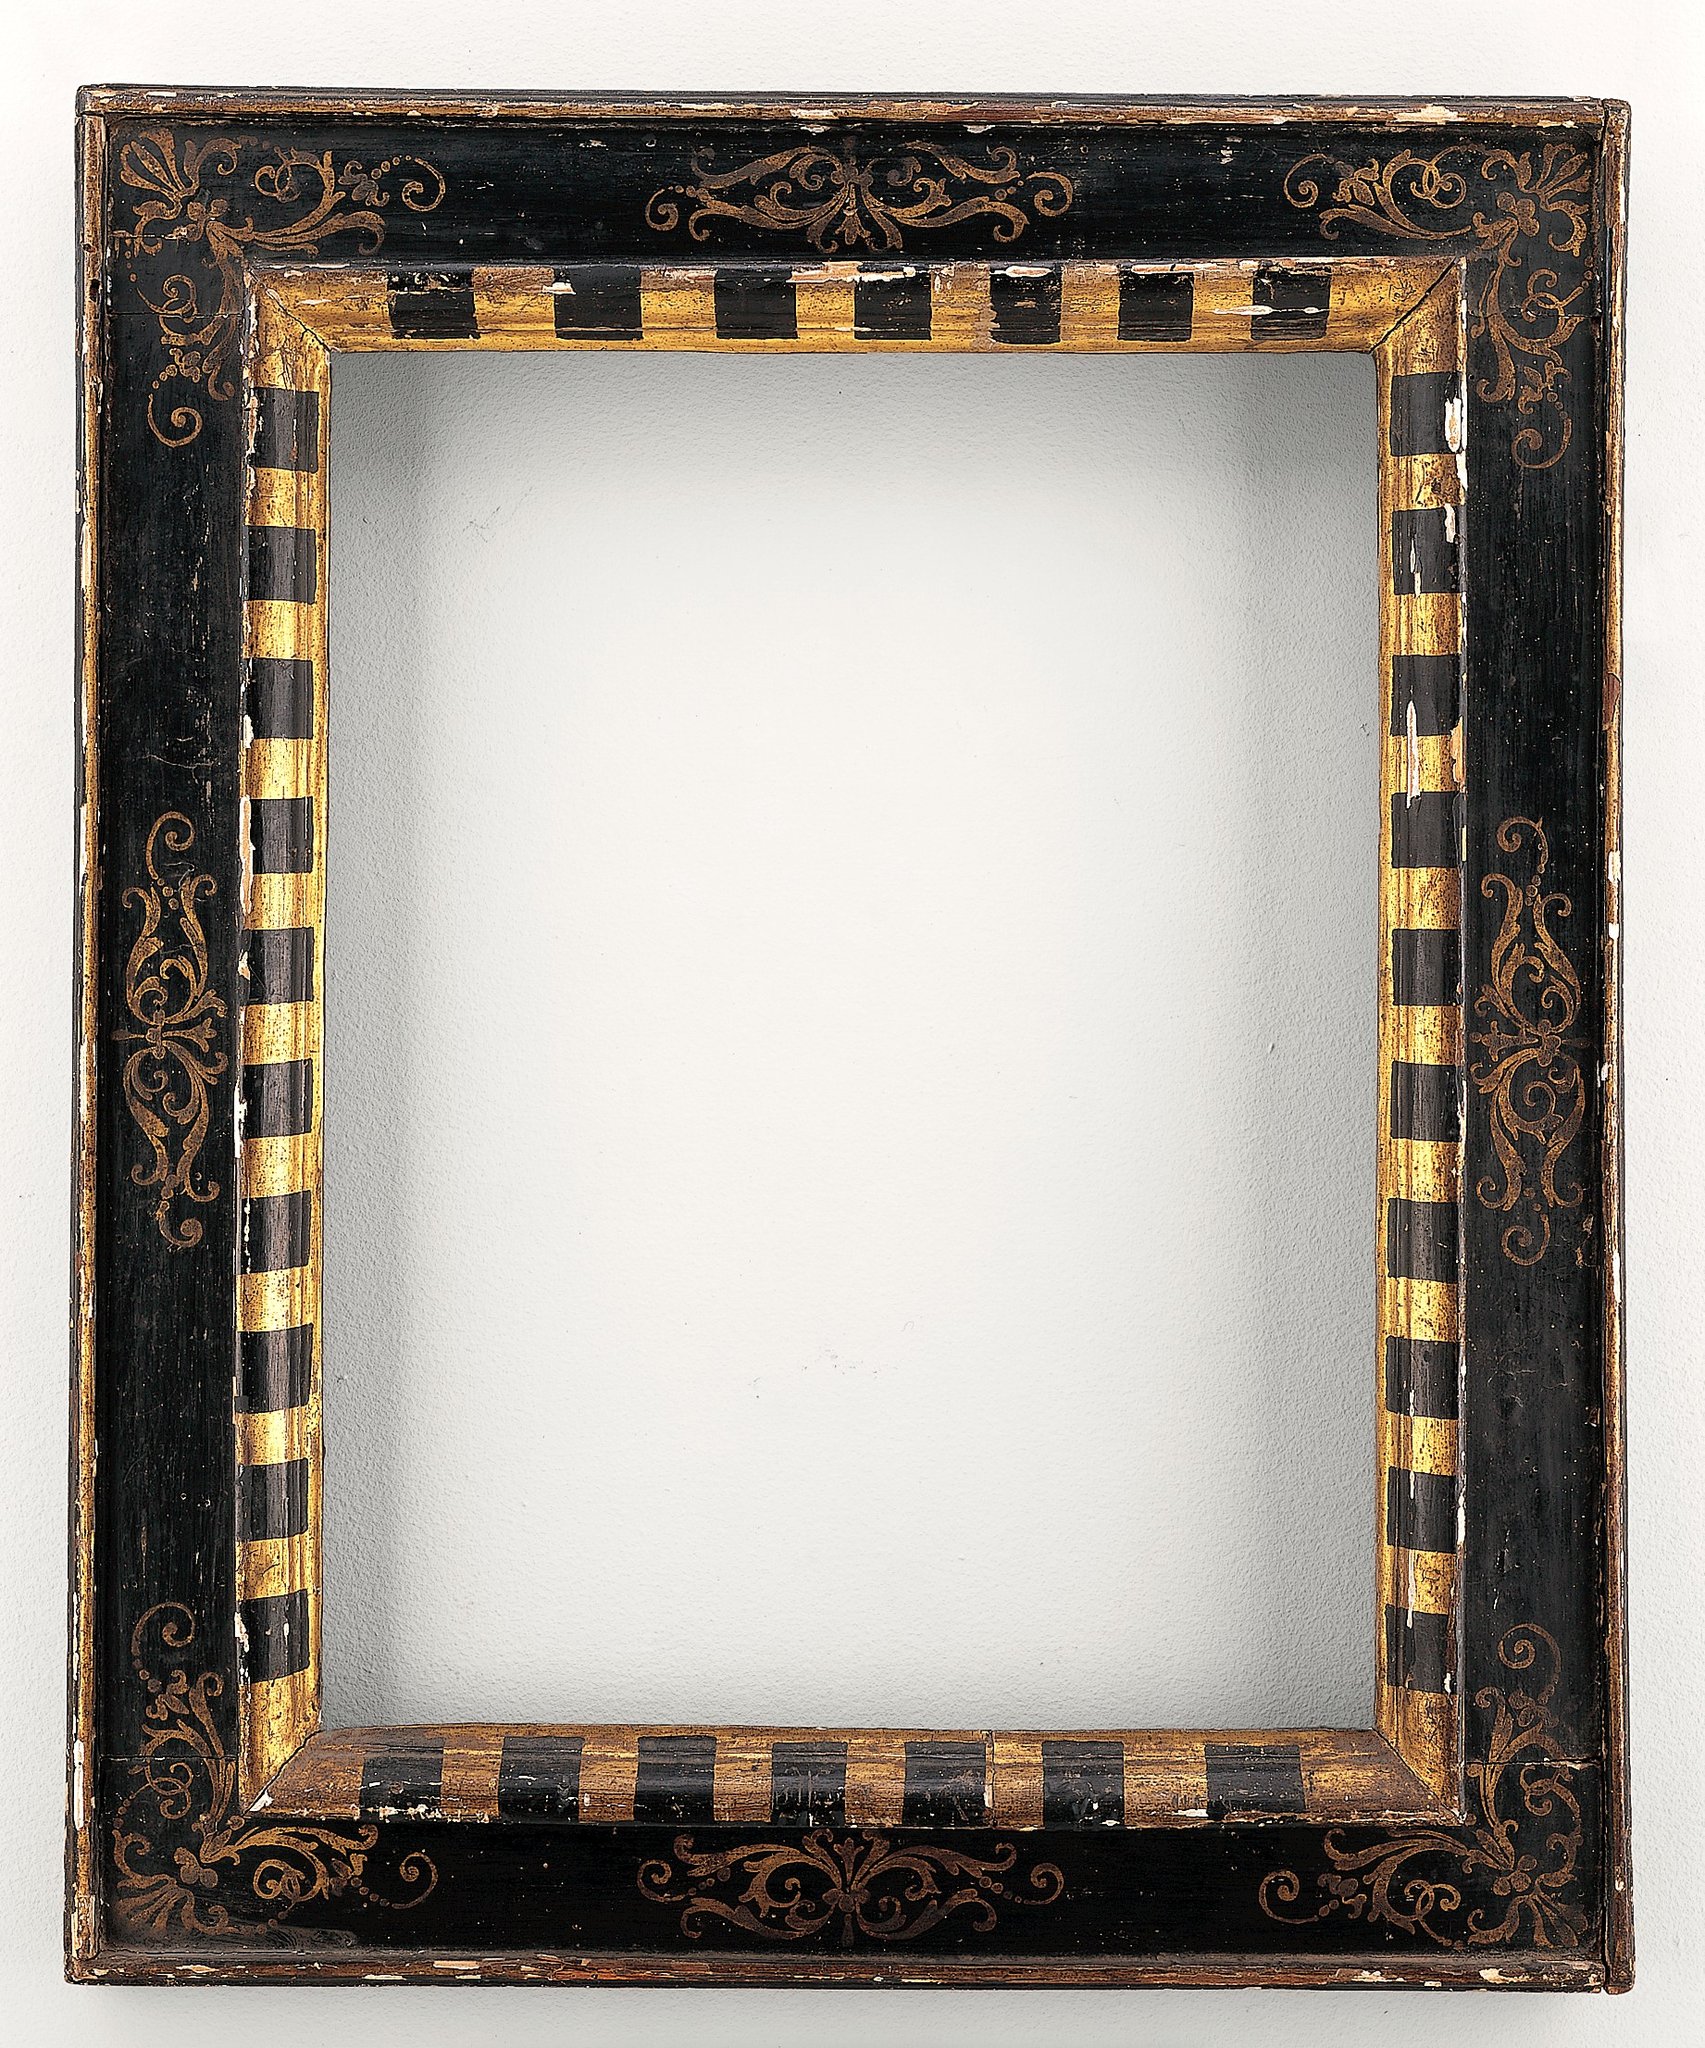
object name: frame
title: Reverse cassetta frame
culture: italian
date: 1640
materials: wood